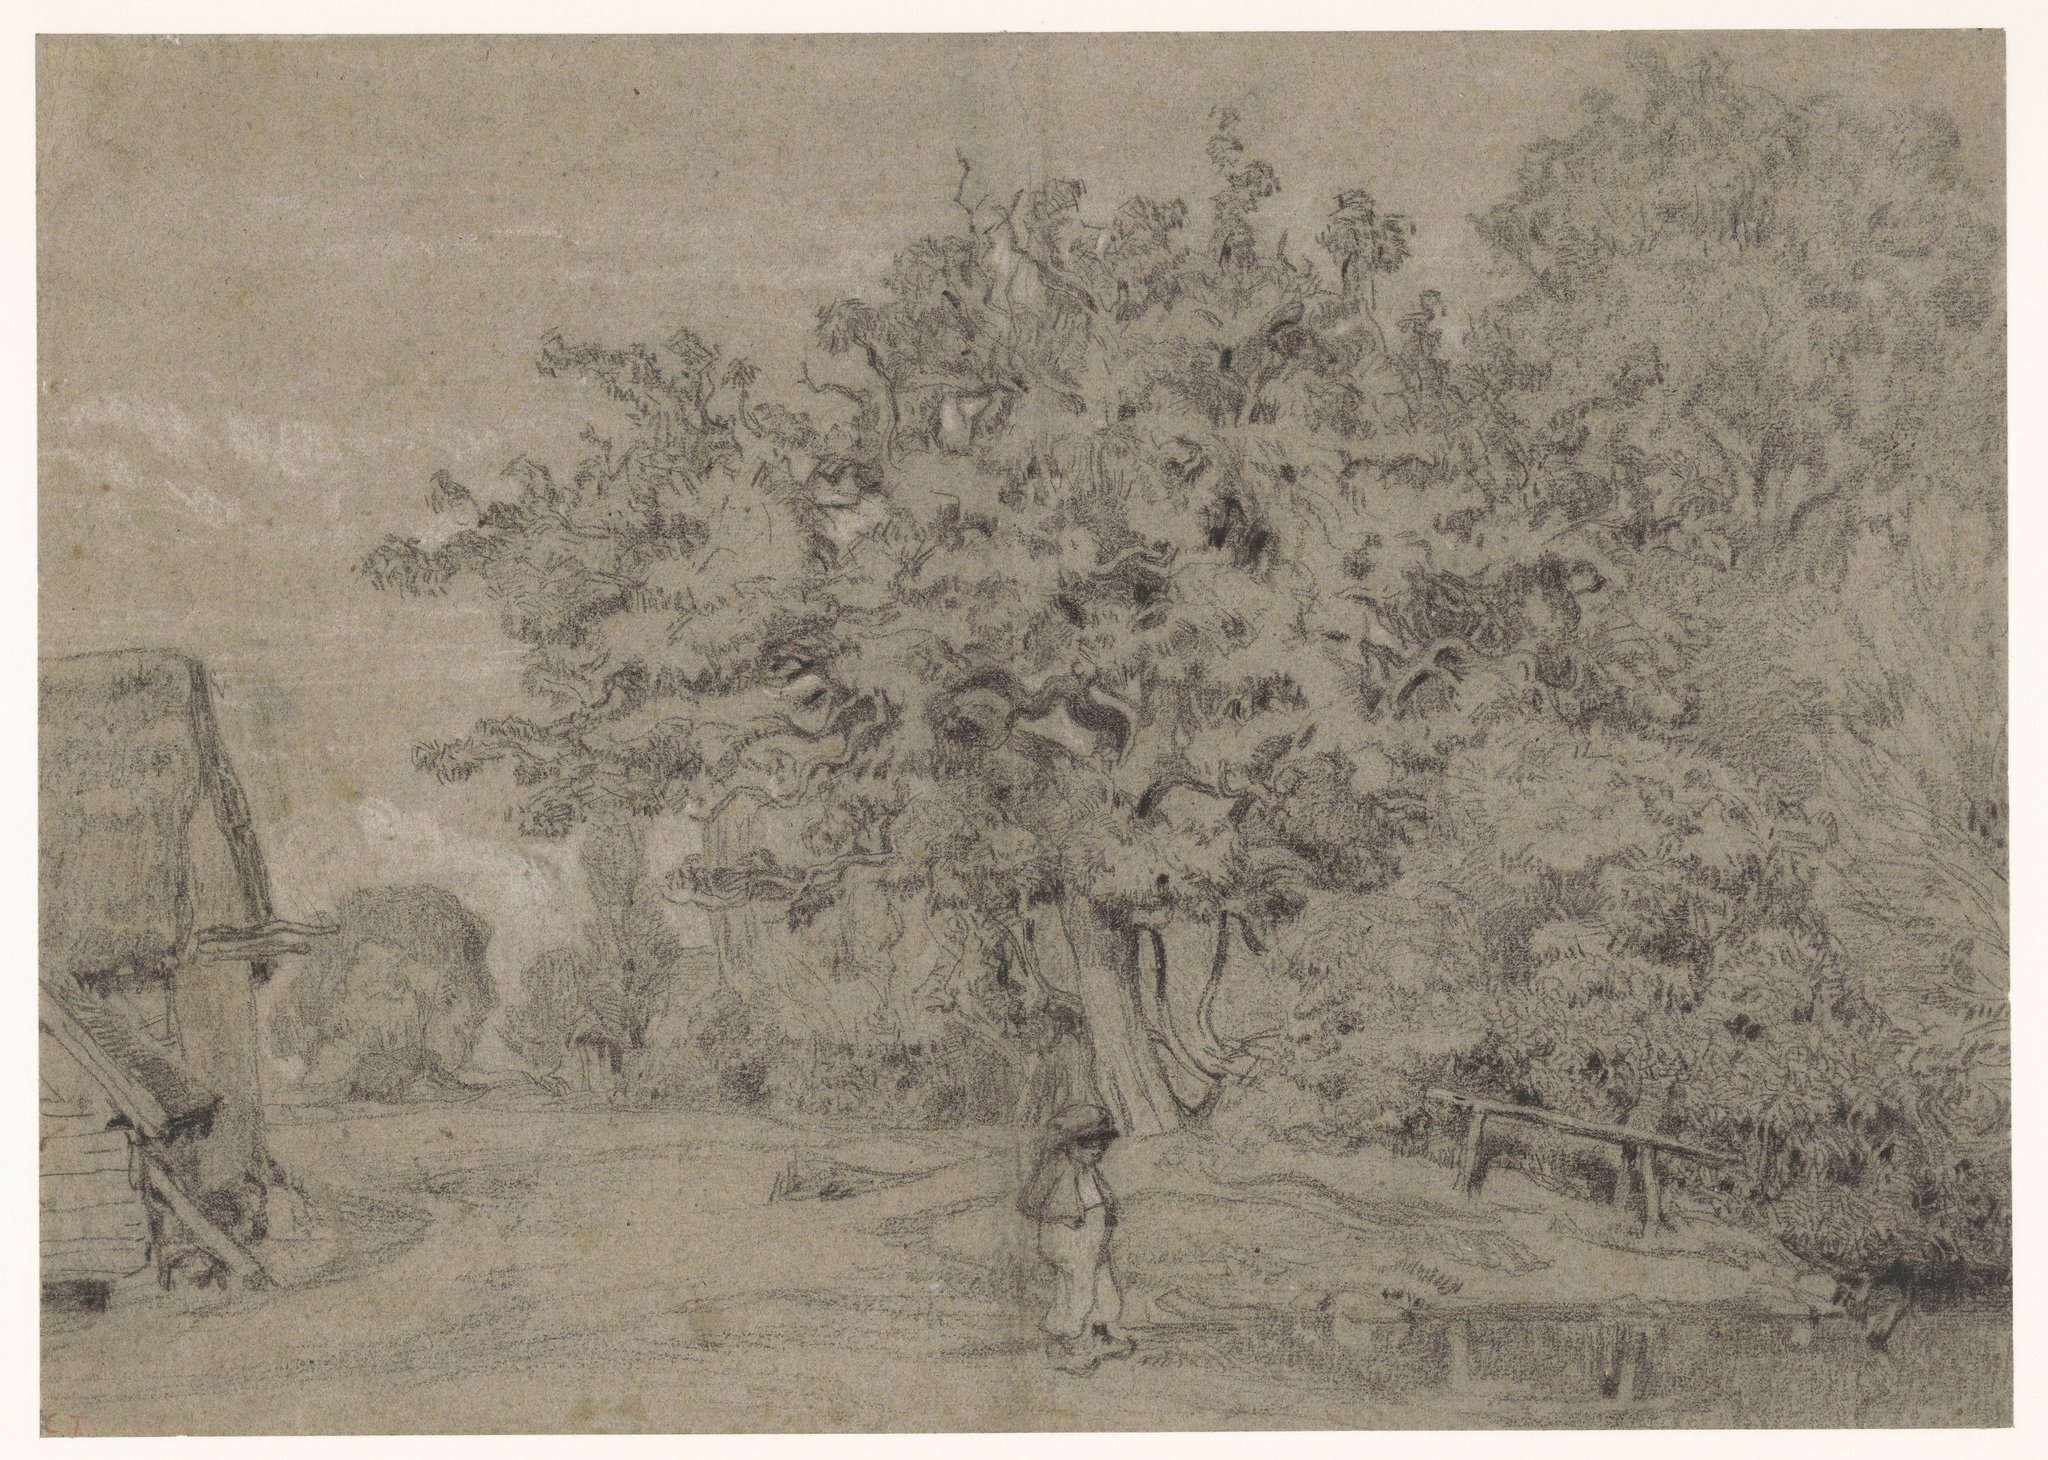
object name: drawing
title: Oude boom bij een boerderij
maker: constant troyon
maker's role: draughtsman, painter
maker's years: 1810-1865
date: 1820-1865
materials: chalk, paper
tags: farm or solitary house in landscape